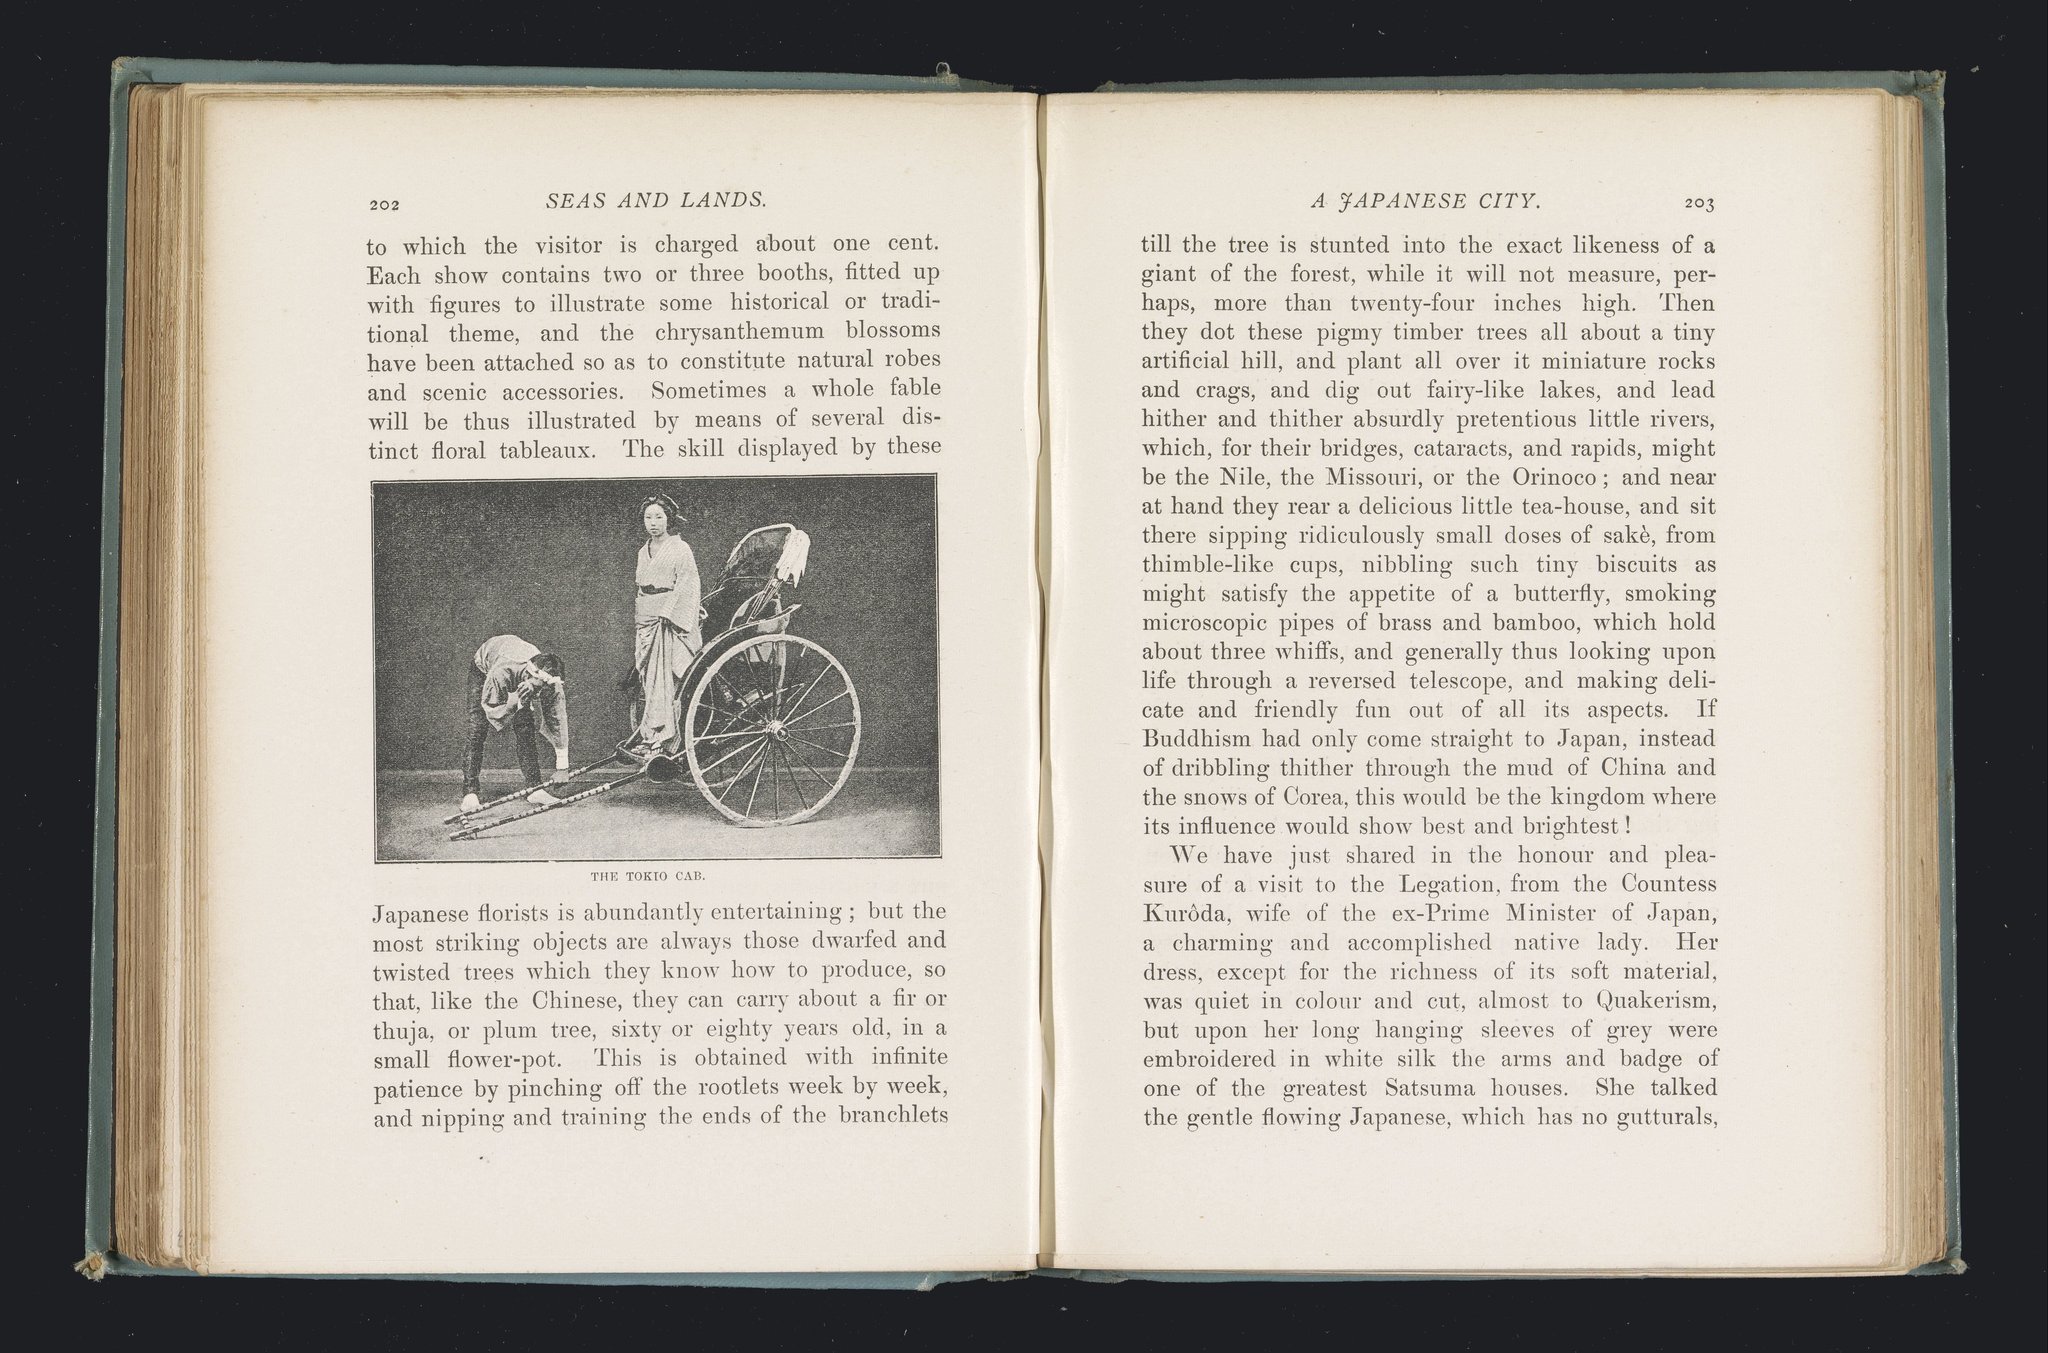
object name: page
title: The Tokio cab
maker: Anonymous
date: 1882-1892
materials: paper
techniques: autotype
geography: japan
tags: rickshaw, studio requisites ~ photographer